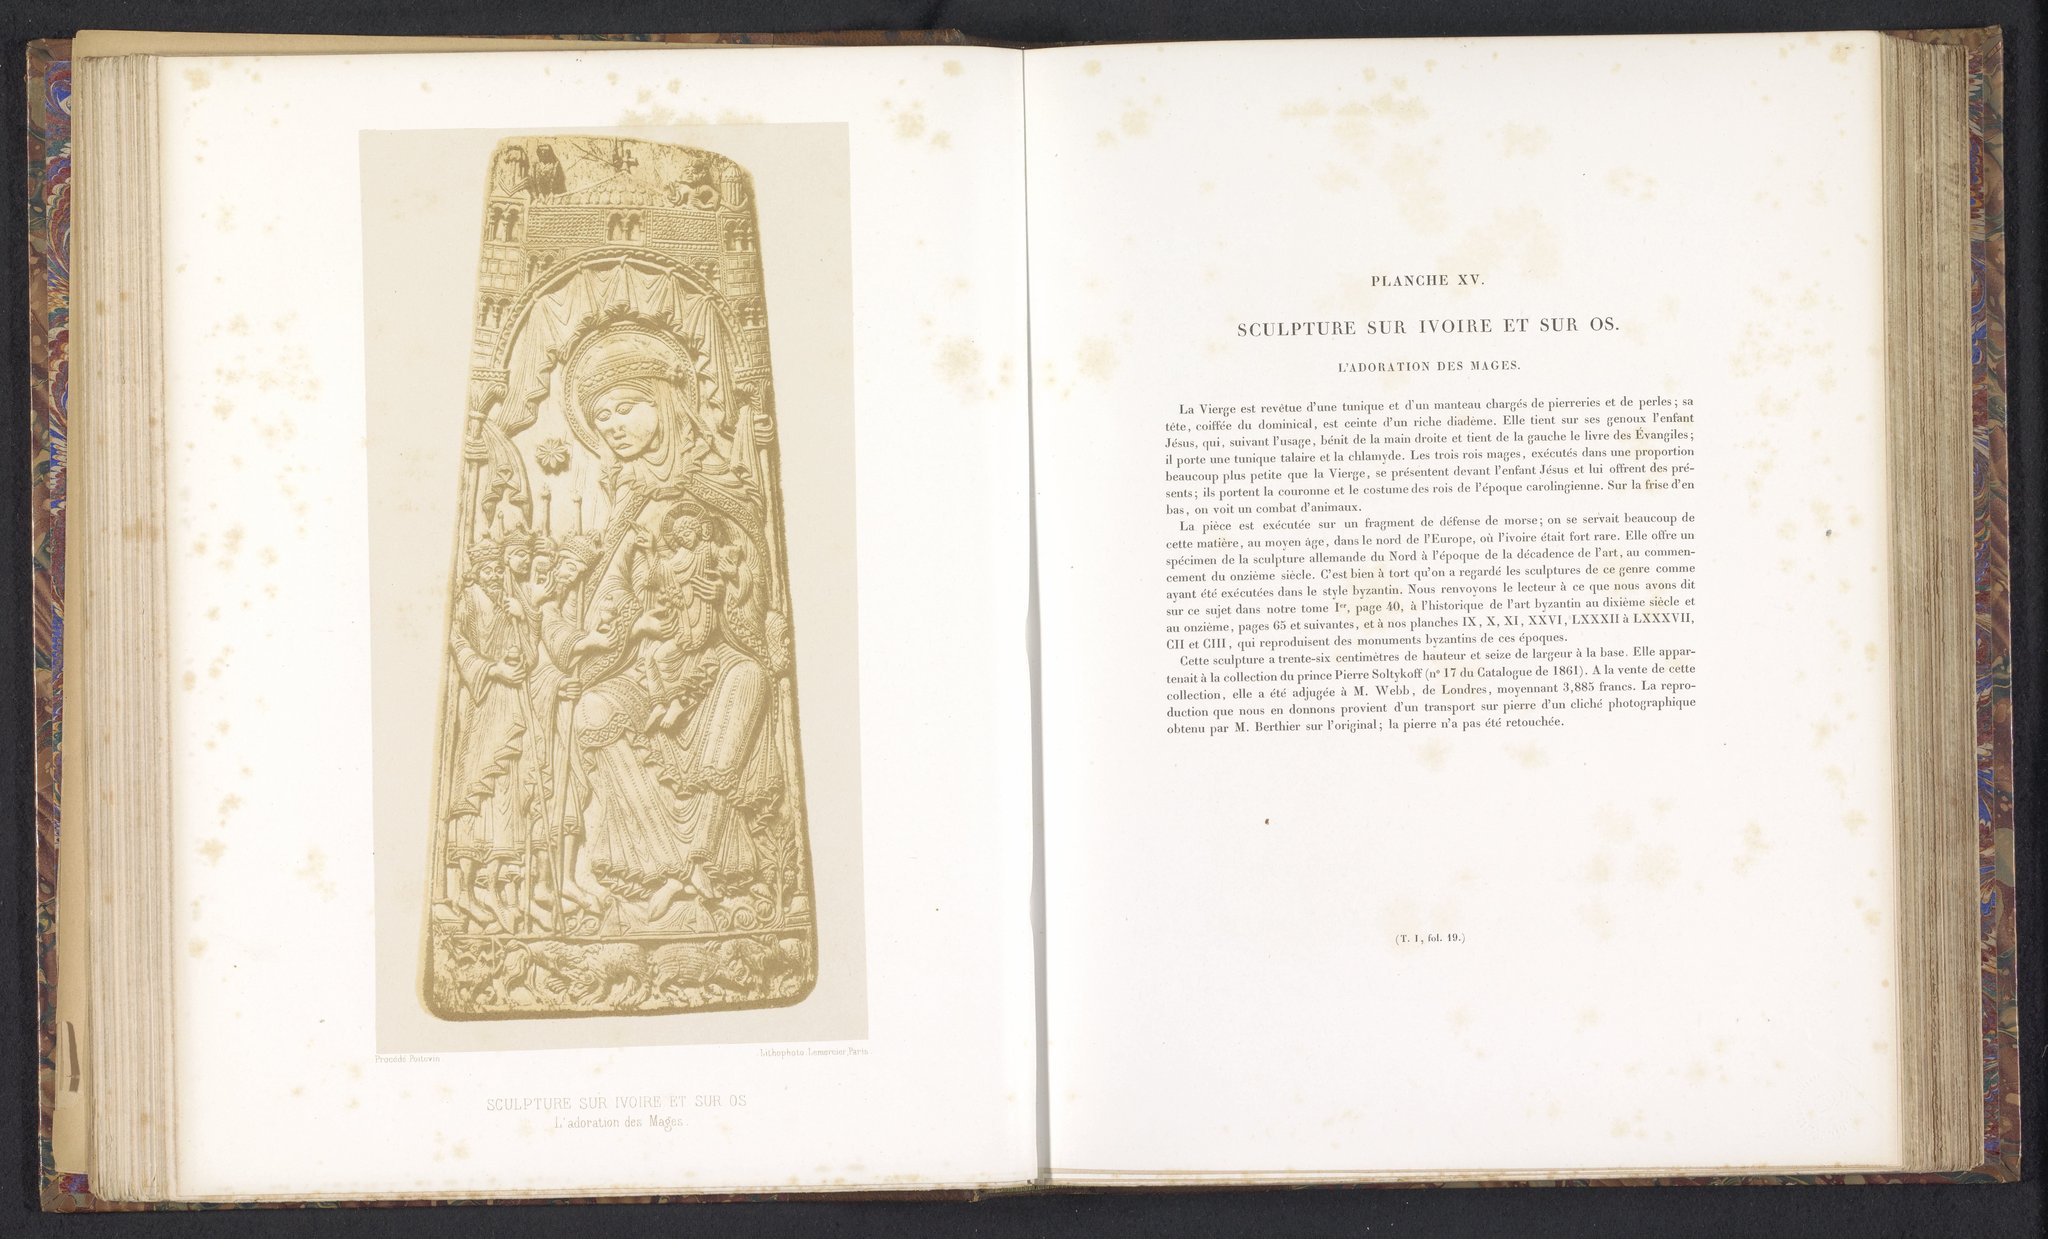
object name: photomechanical print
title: Sculpture en ivoire et sur os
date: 1859-1864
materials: paper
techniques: photolithography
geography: paris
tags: adoration of the kings: the wise men present their gifts to the christ-child (gold, frankincense and myrrh), sculpture (+ relief ~ sculpture)